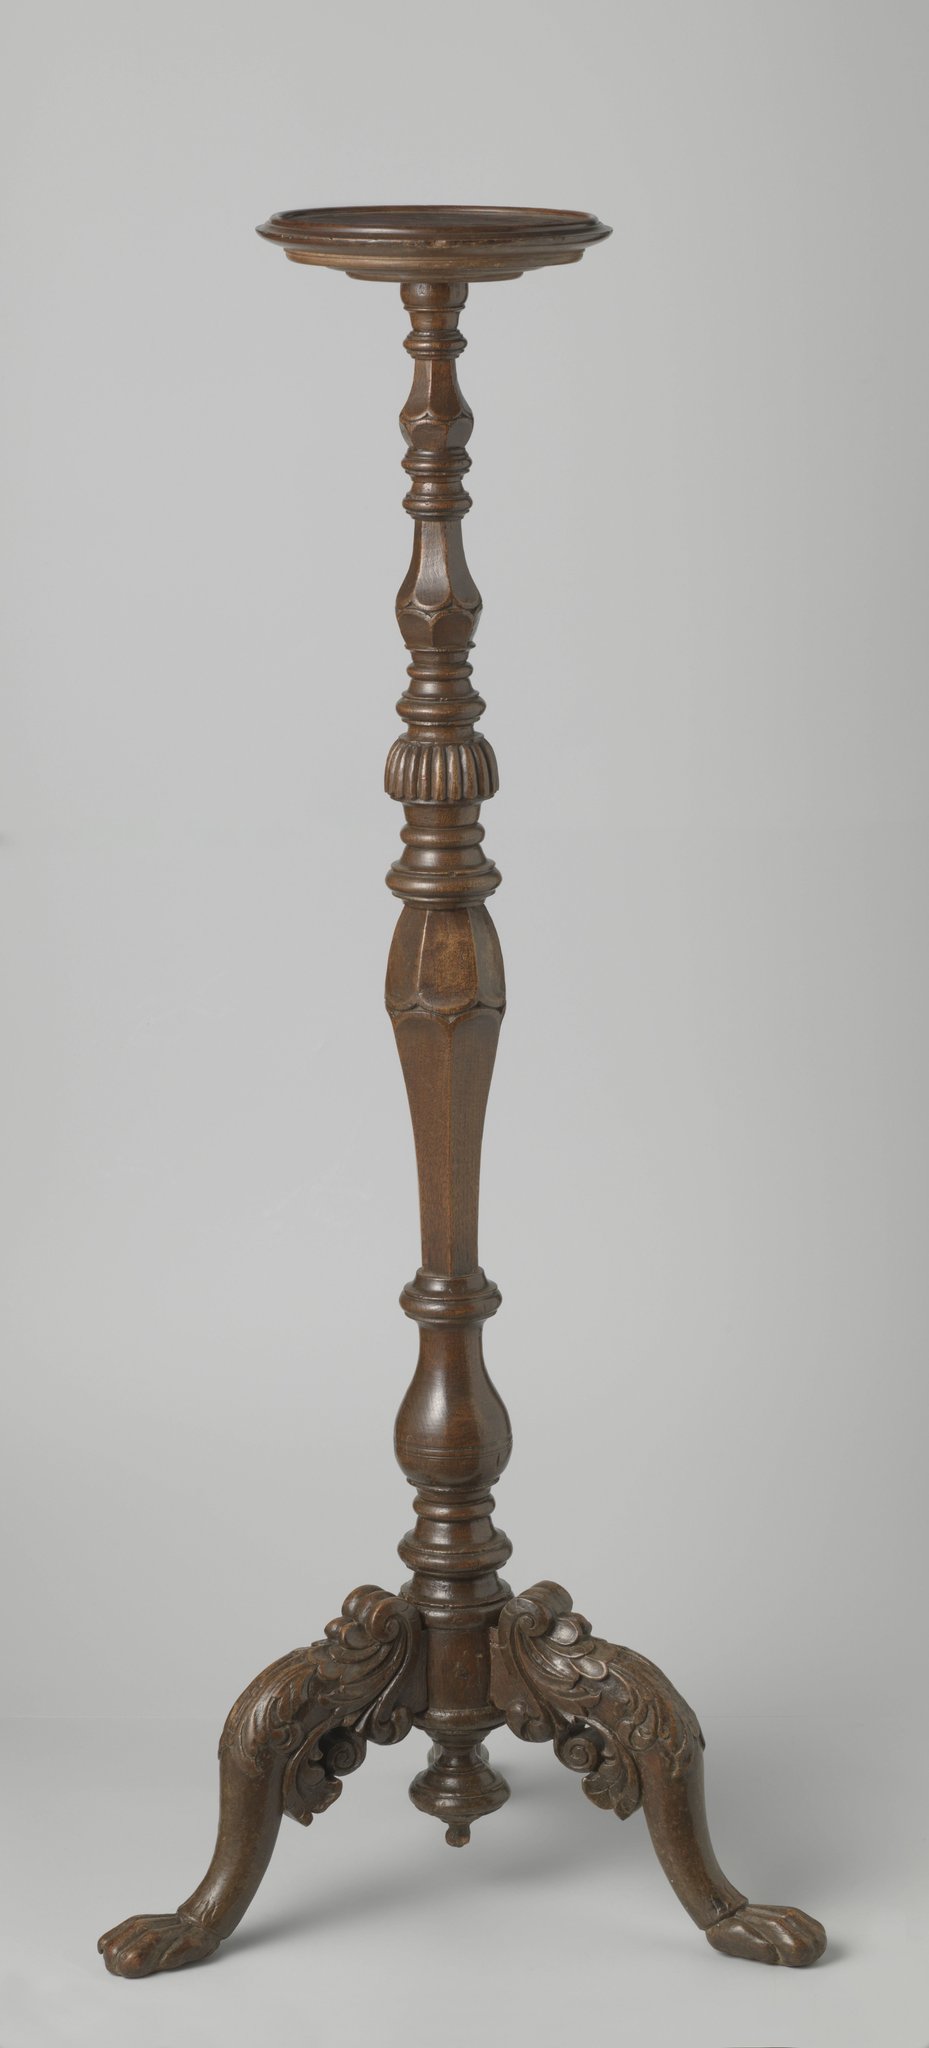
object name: table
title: Guéridon and Lidded Jar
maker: Anonymous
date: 1700-1749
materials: wood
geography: indonesia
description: This stand (guéridon) for a candlestick, vase or bowl graced the home of wealthy Dutchmen in Batavia (now Jakarta, Indonesia) in the 18th century. A special feature of the Japanese lidded jar is that the depiction is not only painted, but also executed in relief. Behind the painted lattices we see people drinking sake and admiring the overhanging cherry blossoms.